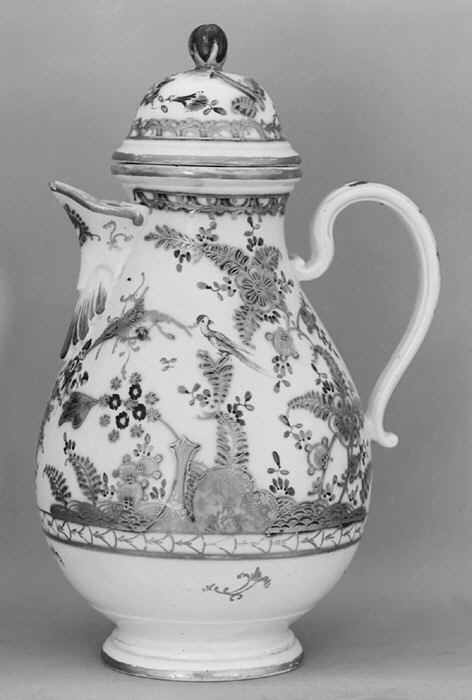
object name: coffeepot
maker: imperial porcelain manufactory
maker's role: manufactory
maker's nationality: austrian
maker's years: 1744-1864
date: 1760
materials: hard paste porcelain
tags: birds,flowers